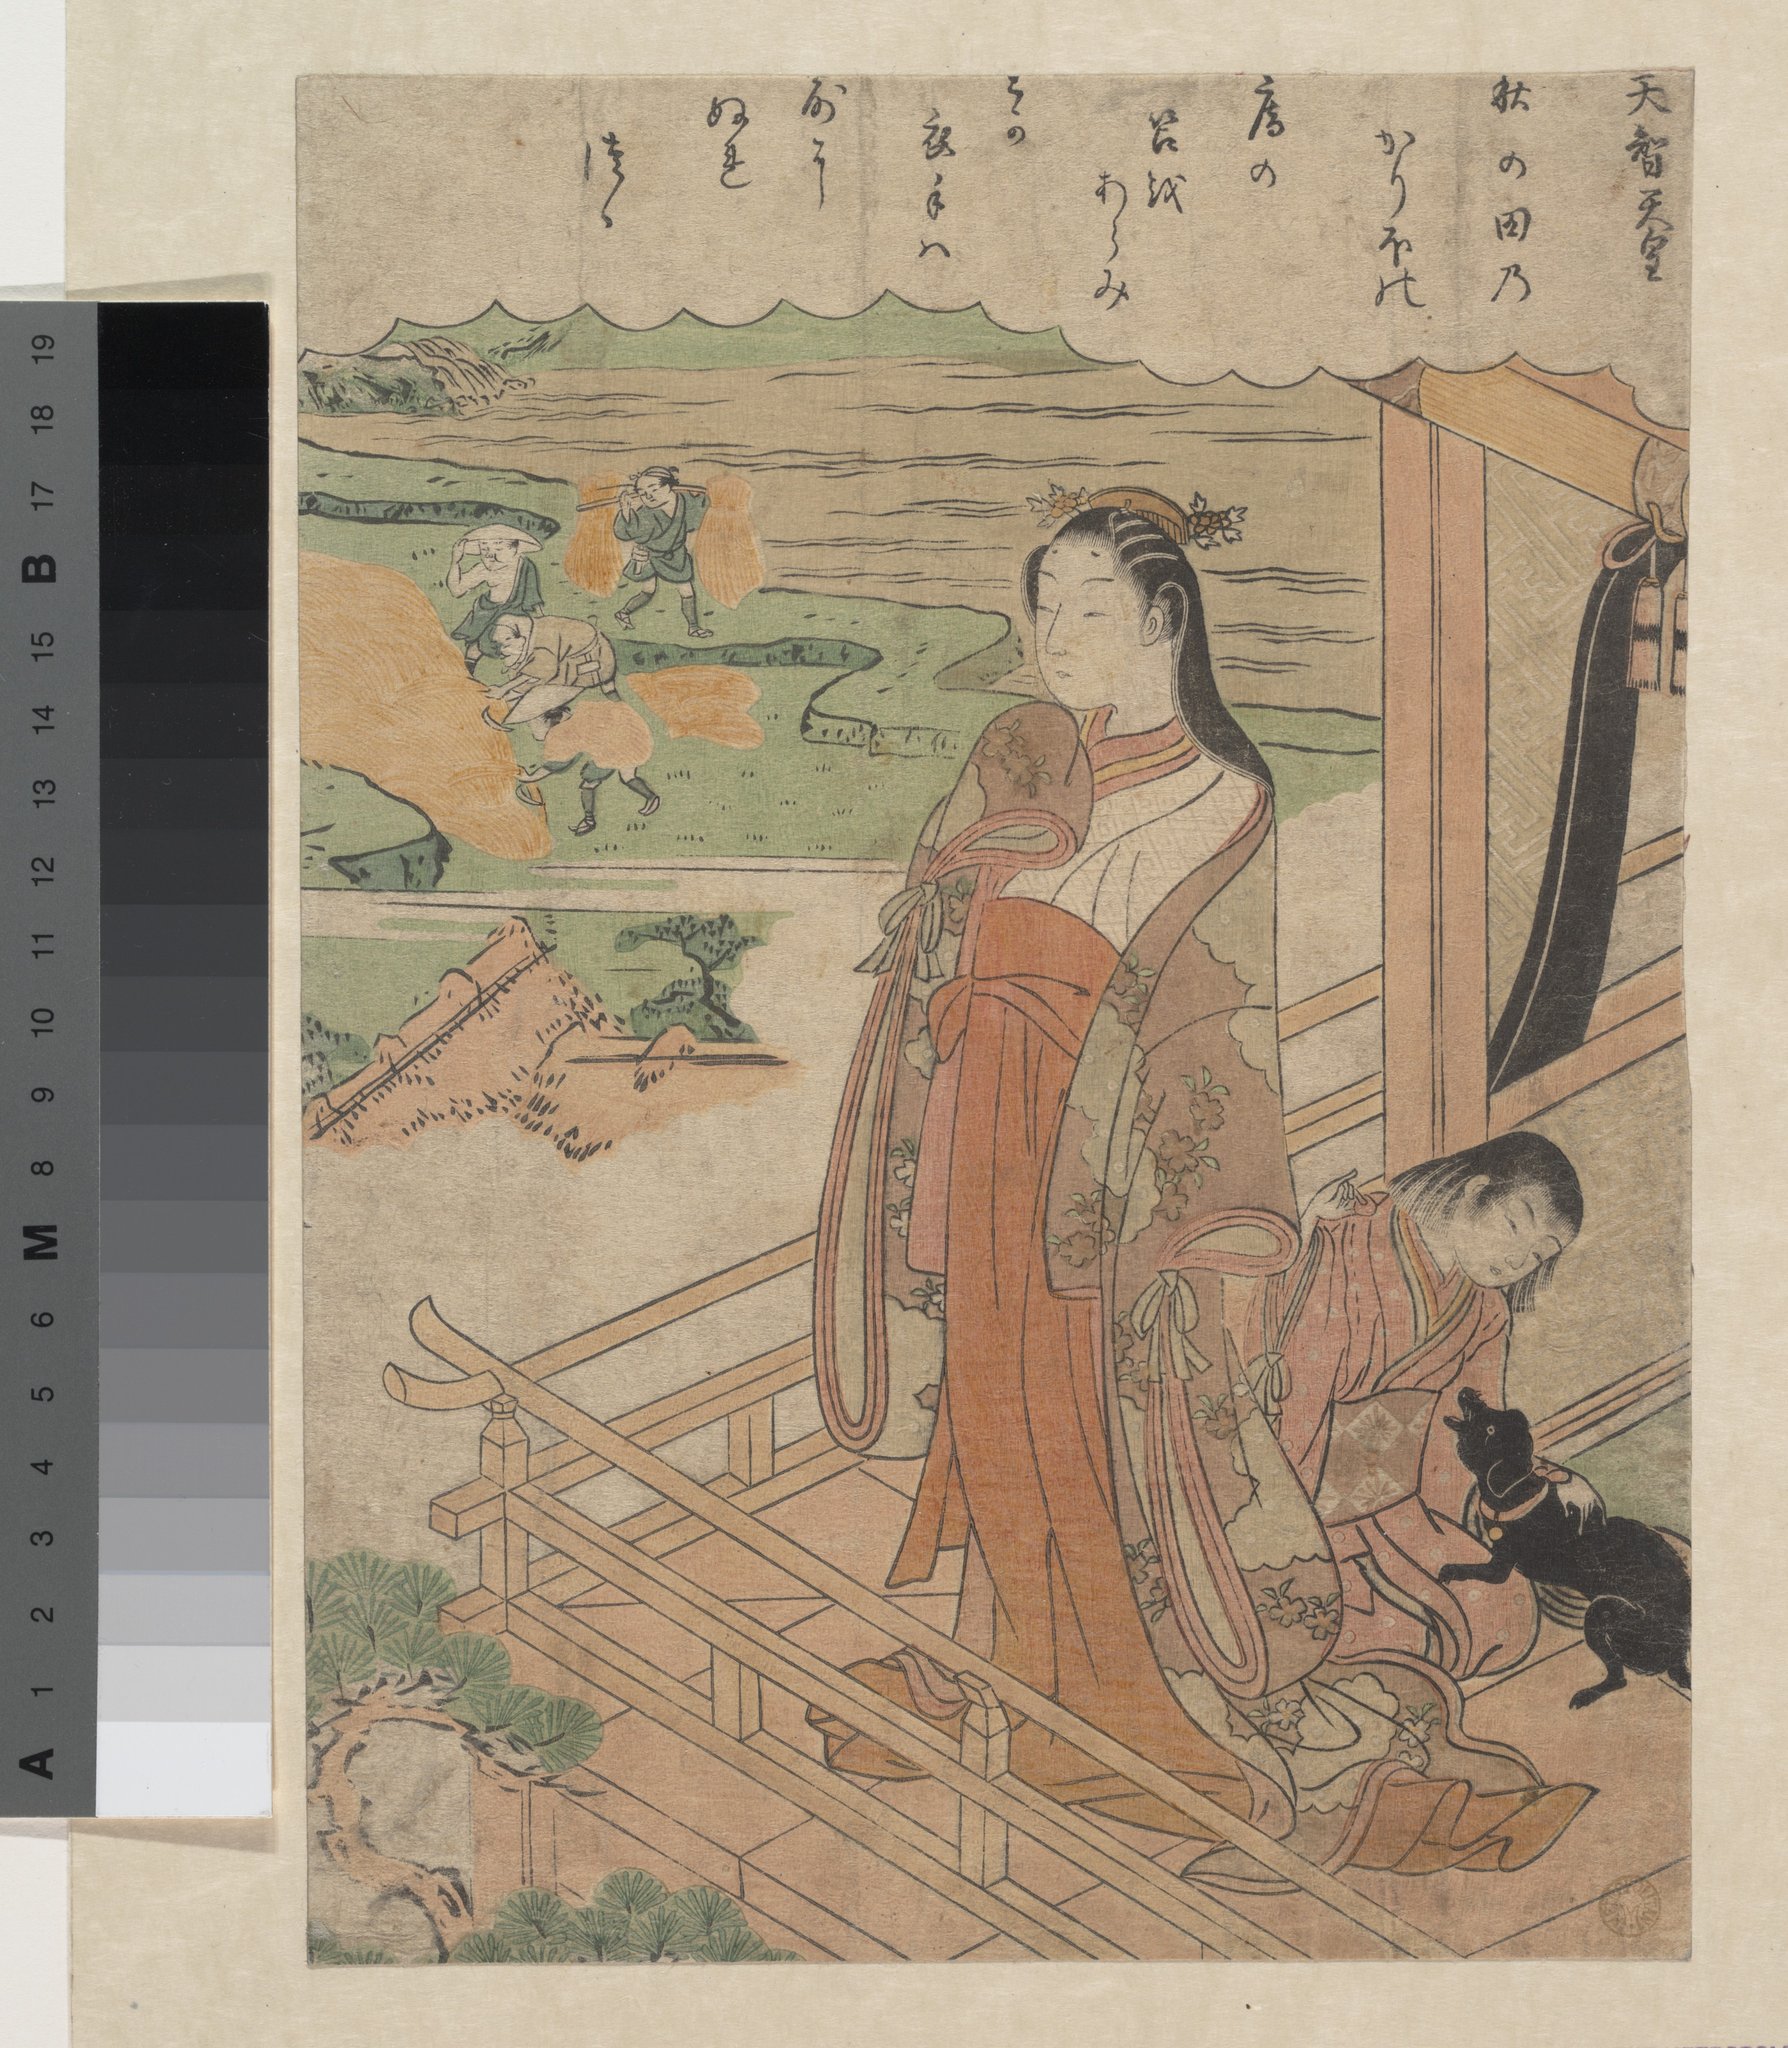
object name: print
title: Sympathy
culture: japanese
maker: suzuki harunobu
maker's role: artist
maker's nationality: japanese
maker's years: 1725-1770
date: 1768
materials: ink, paper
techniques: woodblock print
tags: girls,women,dogs